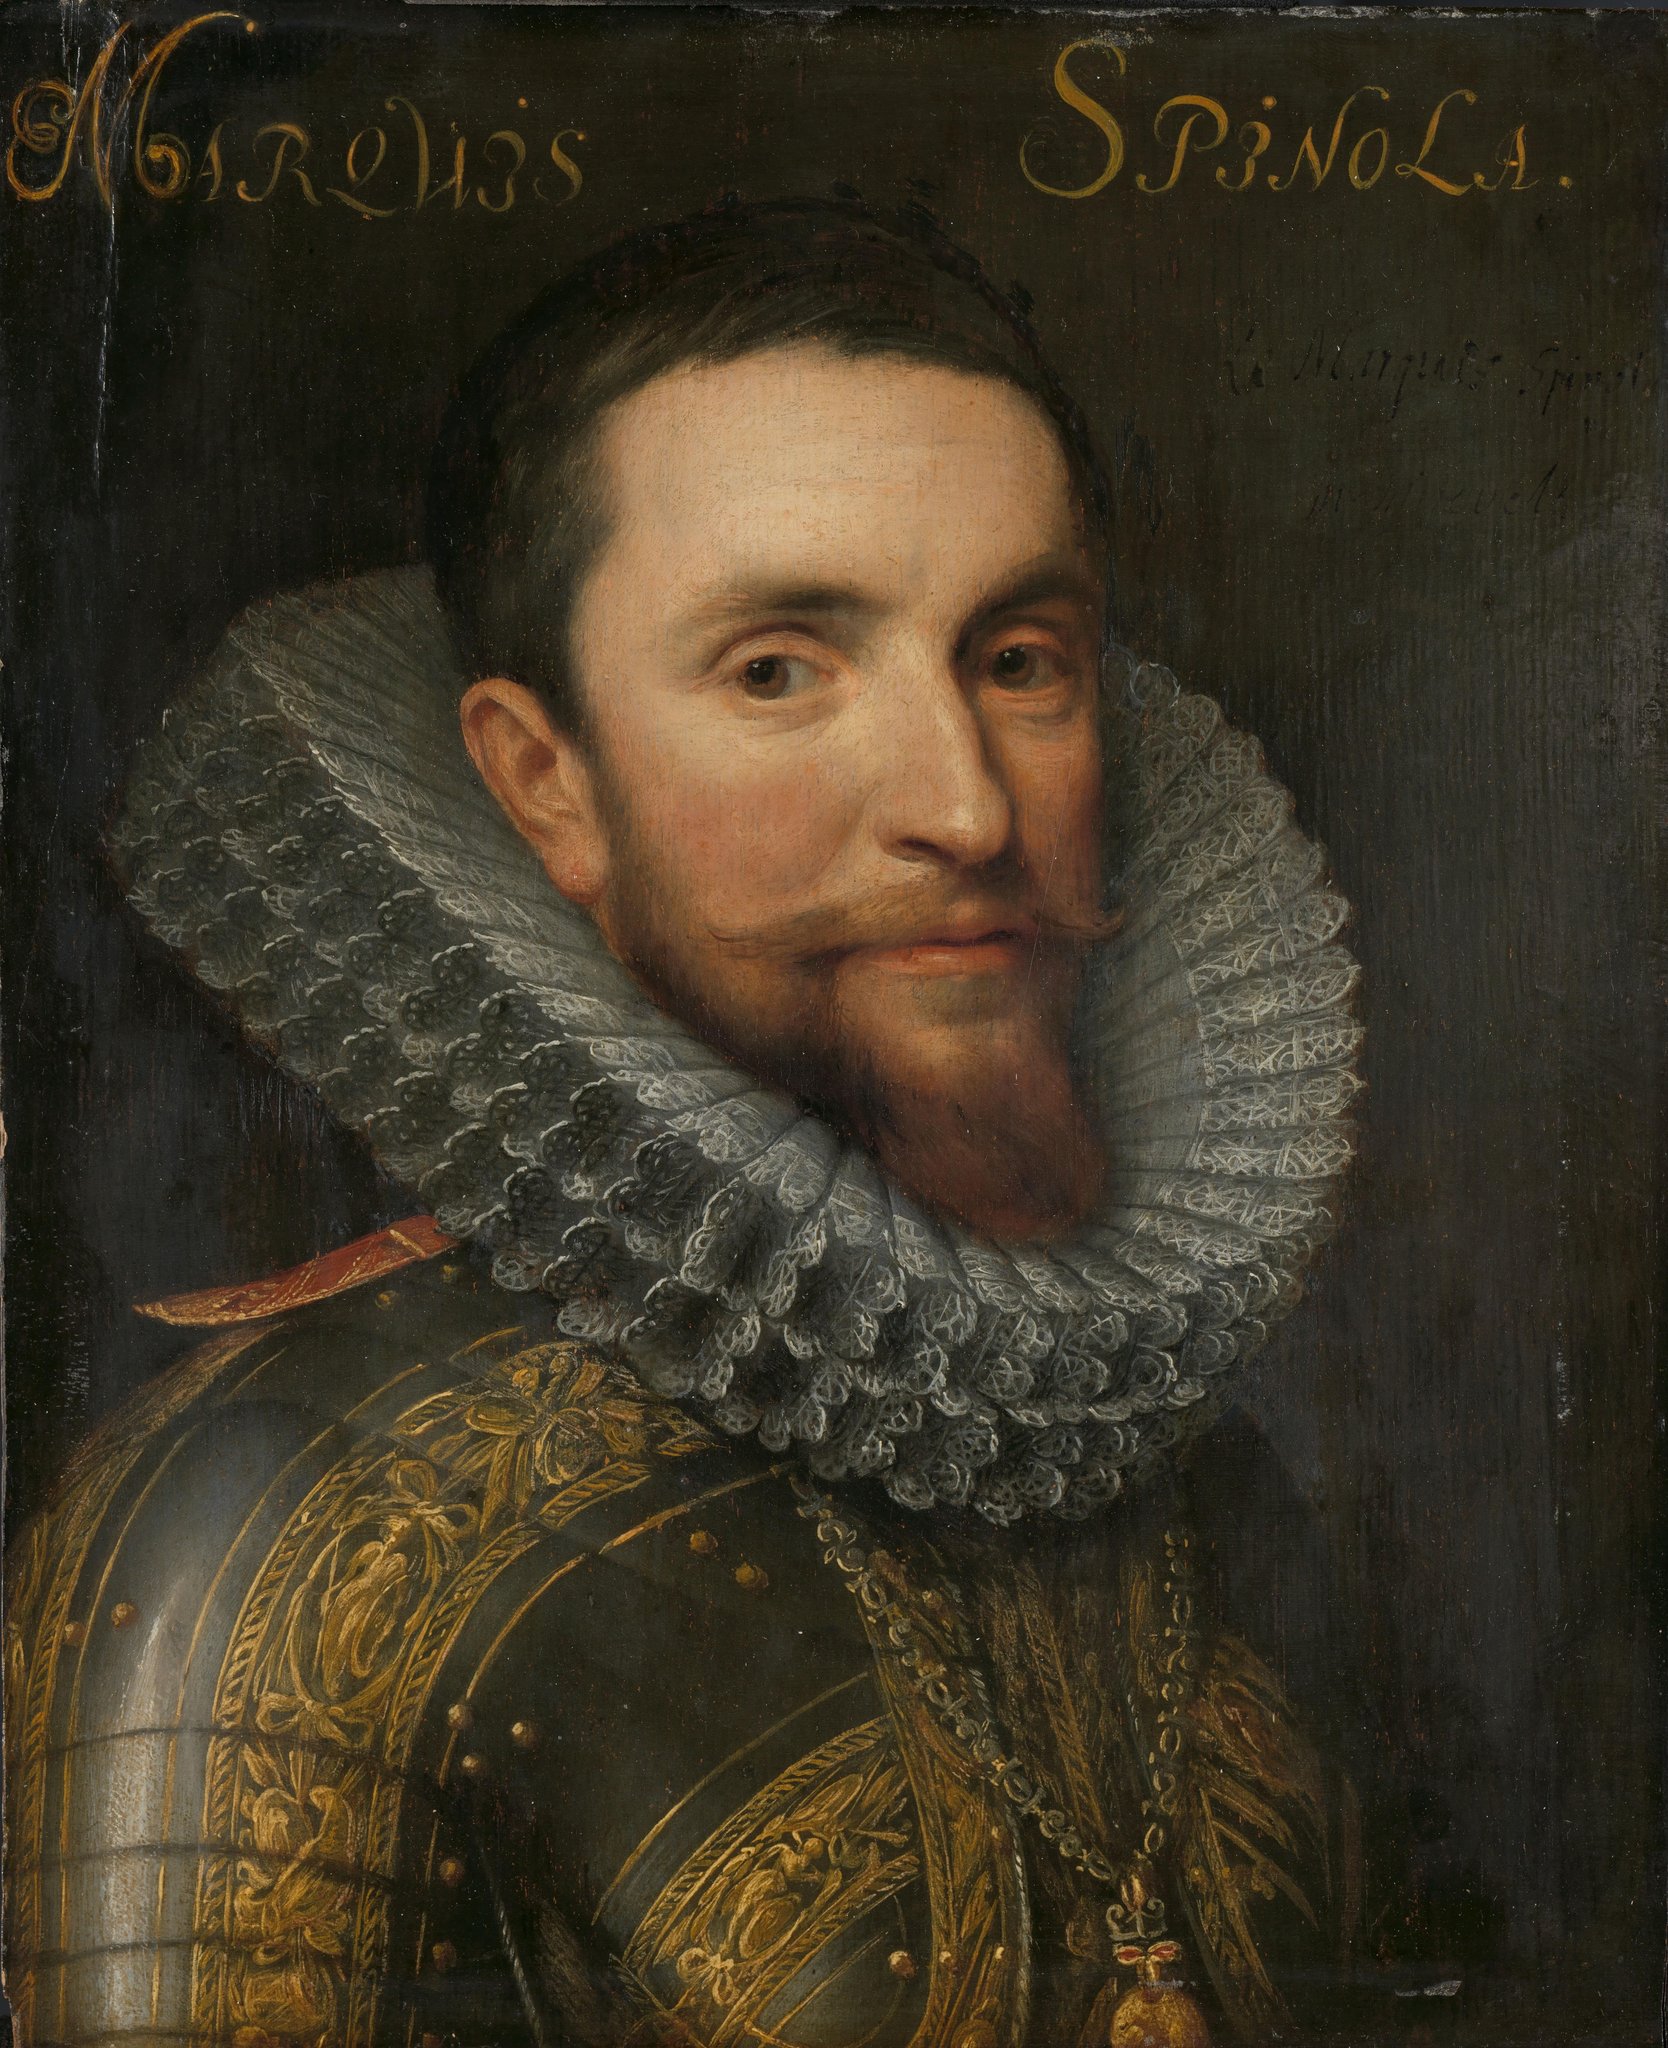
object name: painting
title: Portrait of Ambrogio Spinola (1569-1630)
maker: michiel jansz van mierevelt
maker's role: draughtsman, painter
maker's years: 1567-1641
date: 1609-1633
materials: oil, panel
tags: historical persons, knighthood order of the golden fleece - insignia of a knighthood order, e.g.: badge, chain (with name of order)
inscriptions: inscription, top: ‘MARQUIS SPINOLA’, inscription, upper right: ‘Le Marquis Spinola / M. Mirevelt.’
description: Ambrosio Spinola, markies de los Balbazes (1569-1630), naar M.J. van Miereveld.